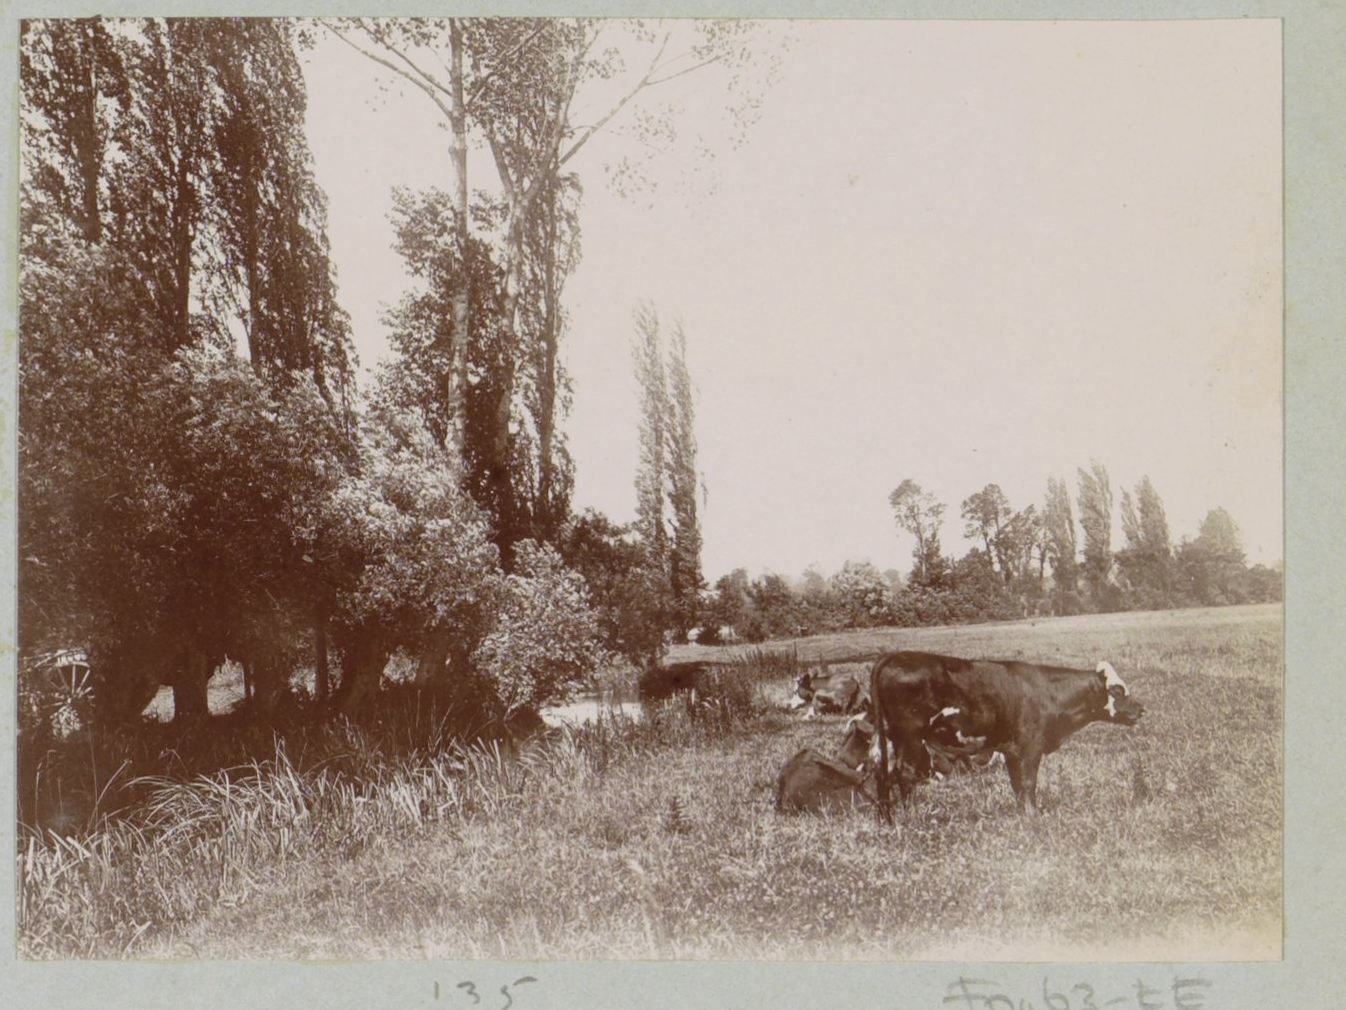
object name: photograph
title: Landschap met koeien aan de oevers van een beek, vermoedelijk bij Lisieux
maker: delizy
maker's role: manufacturer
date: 1808-1897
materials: paper, photographic support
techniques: gelatin silver print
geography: lisieux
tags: cow, river bank, river (+ landscape with figures, staffage)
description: Onderdeel van Fotoalbum van een Franse amateurfotograaf met opnames van uitstapjes in Frankrijk, Spanje, België, Luxemburg en Nederland, de eerste automobielen en autoraces.